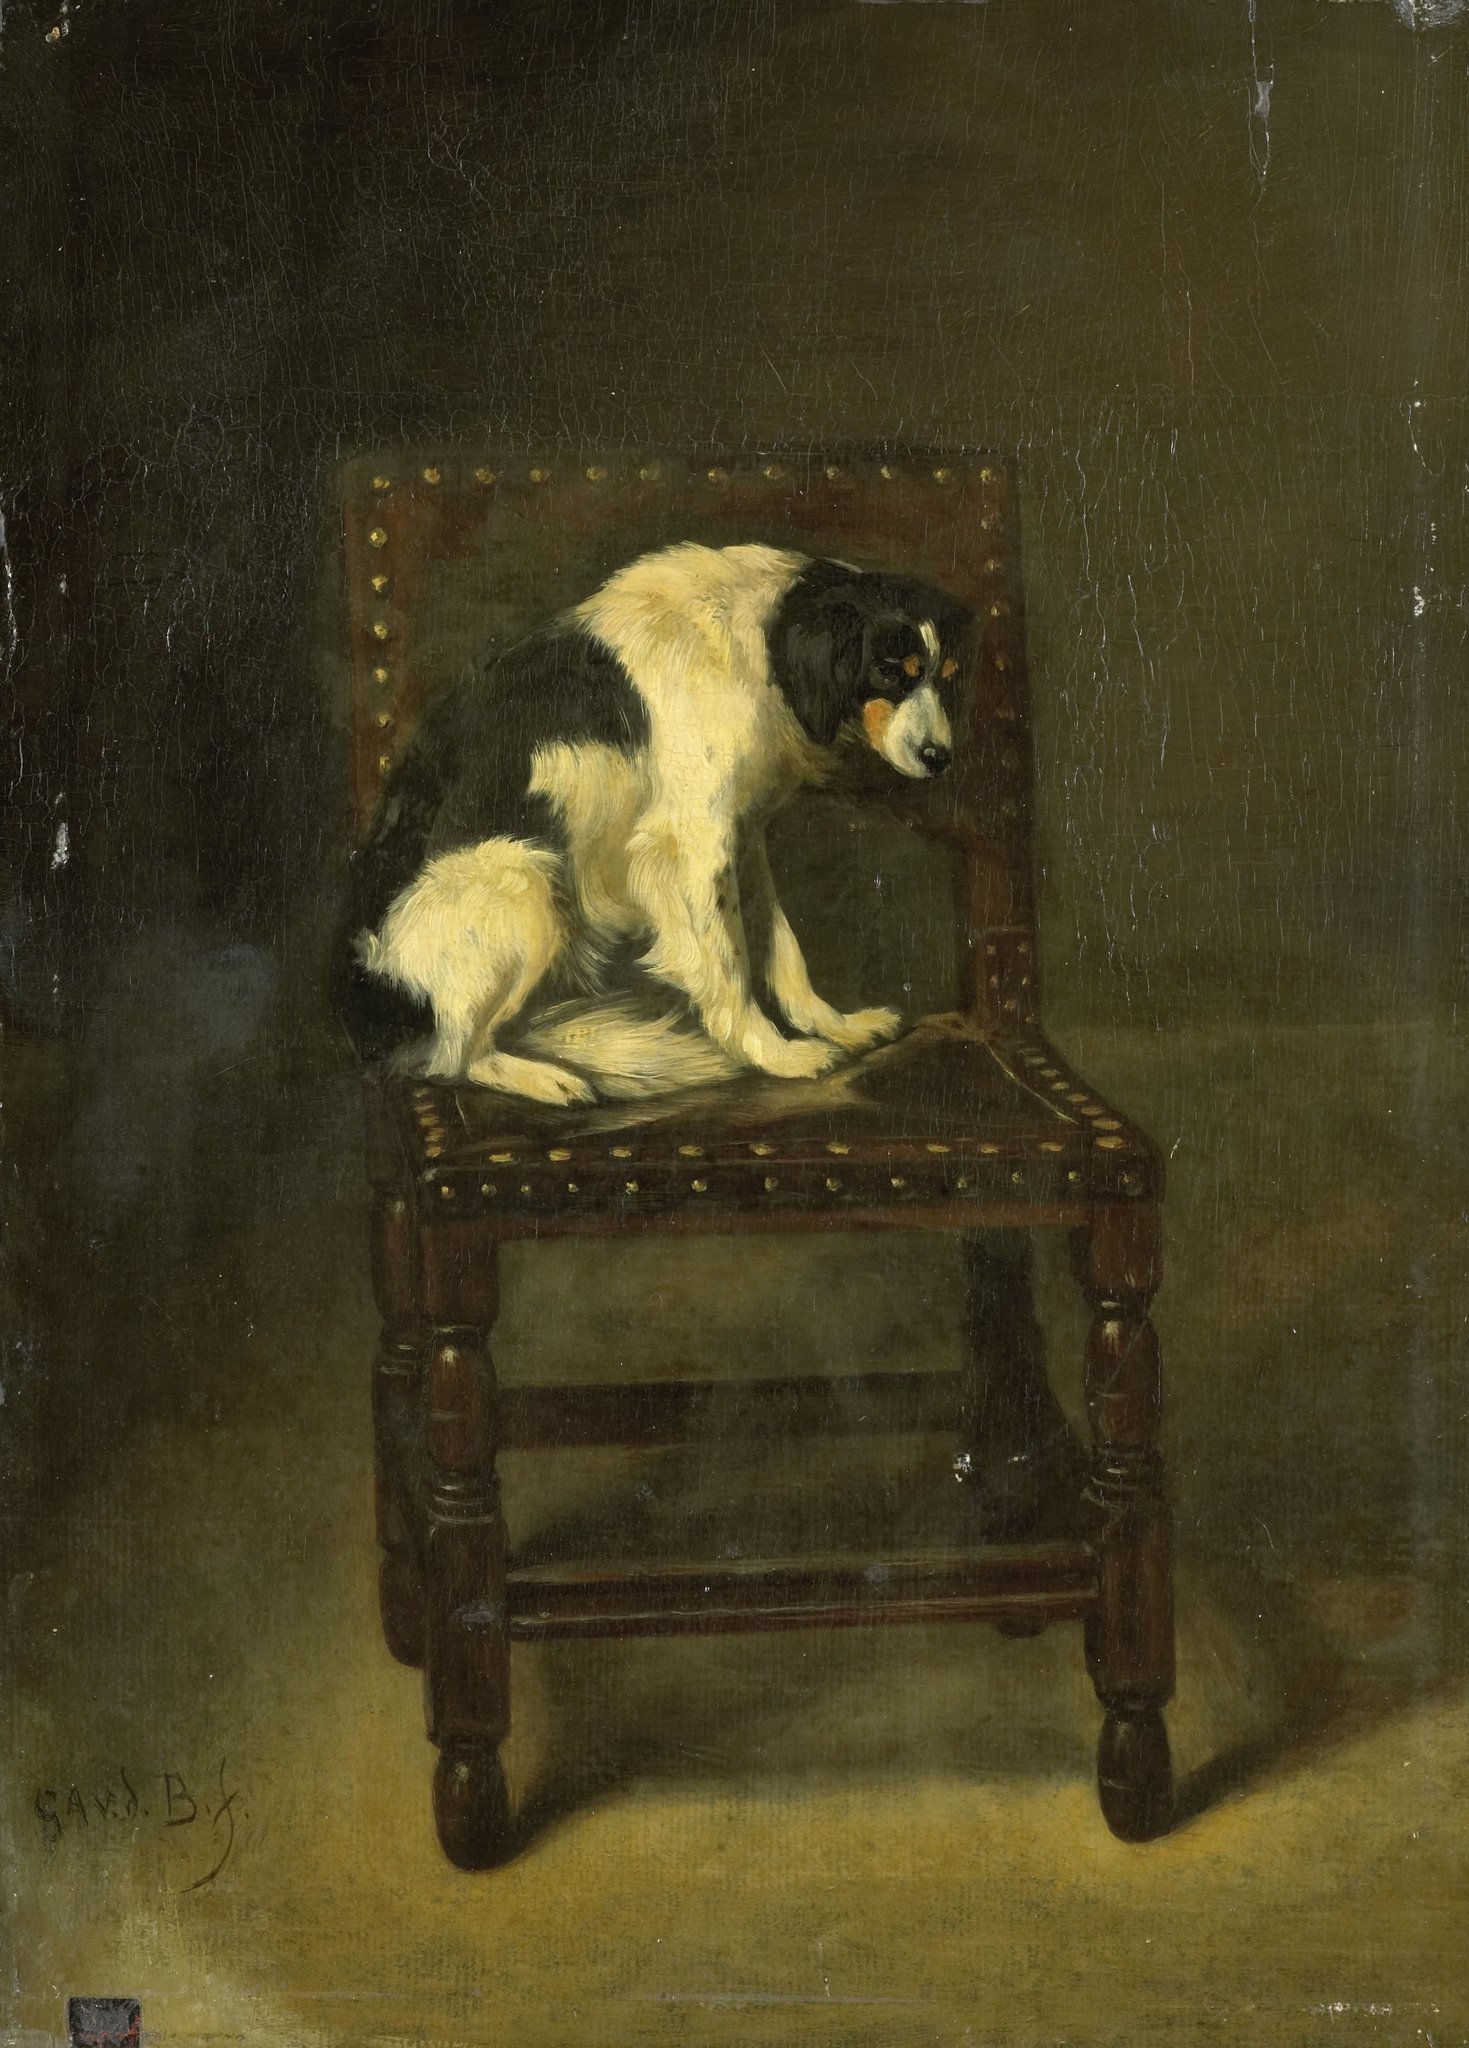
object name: painting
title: A Dog on a Chair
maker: guillaume anne van der brugghen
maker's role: draughtsman, print maker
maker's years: 1812-1891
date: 1860-1891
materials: oil, panel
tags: chair, dog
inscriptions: signature: ‘G.A.v.d.B.f.’